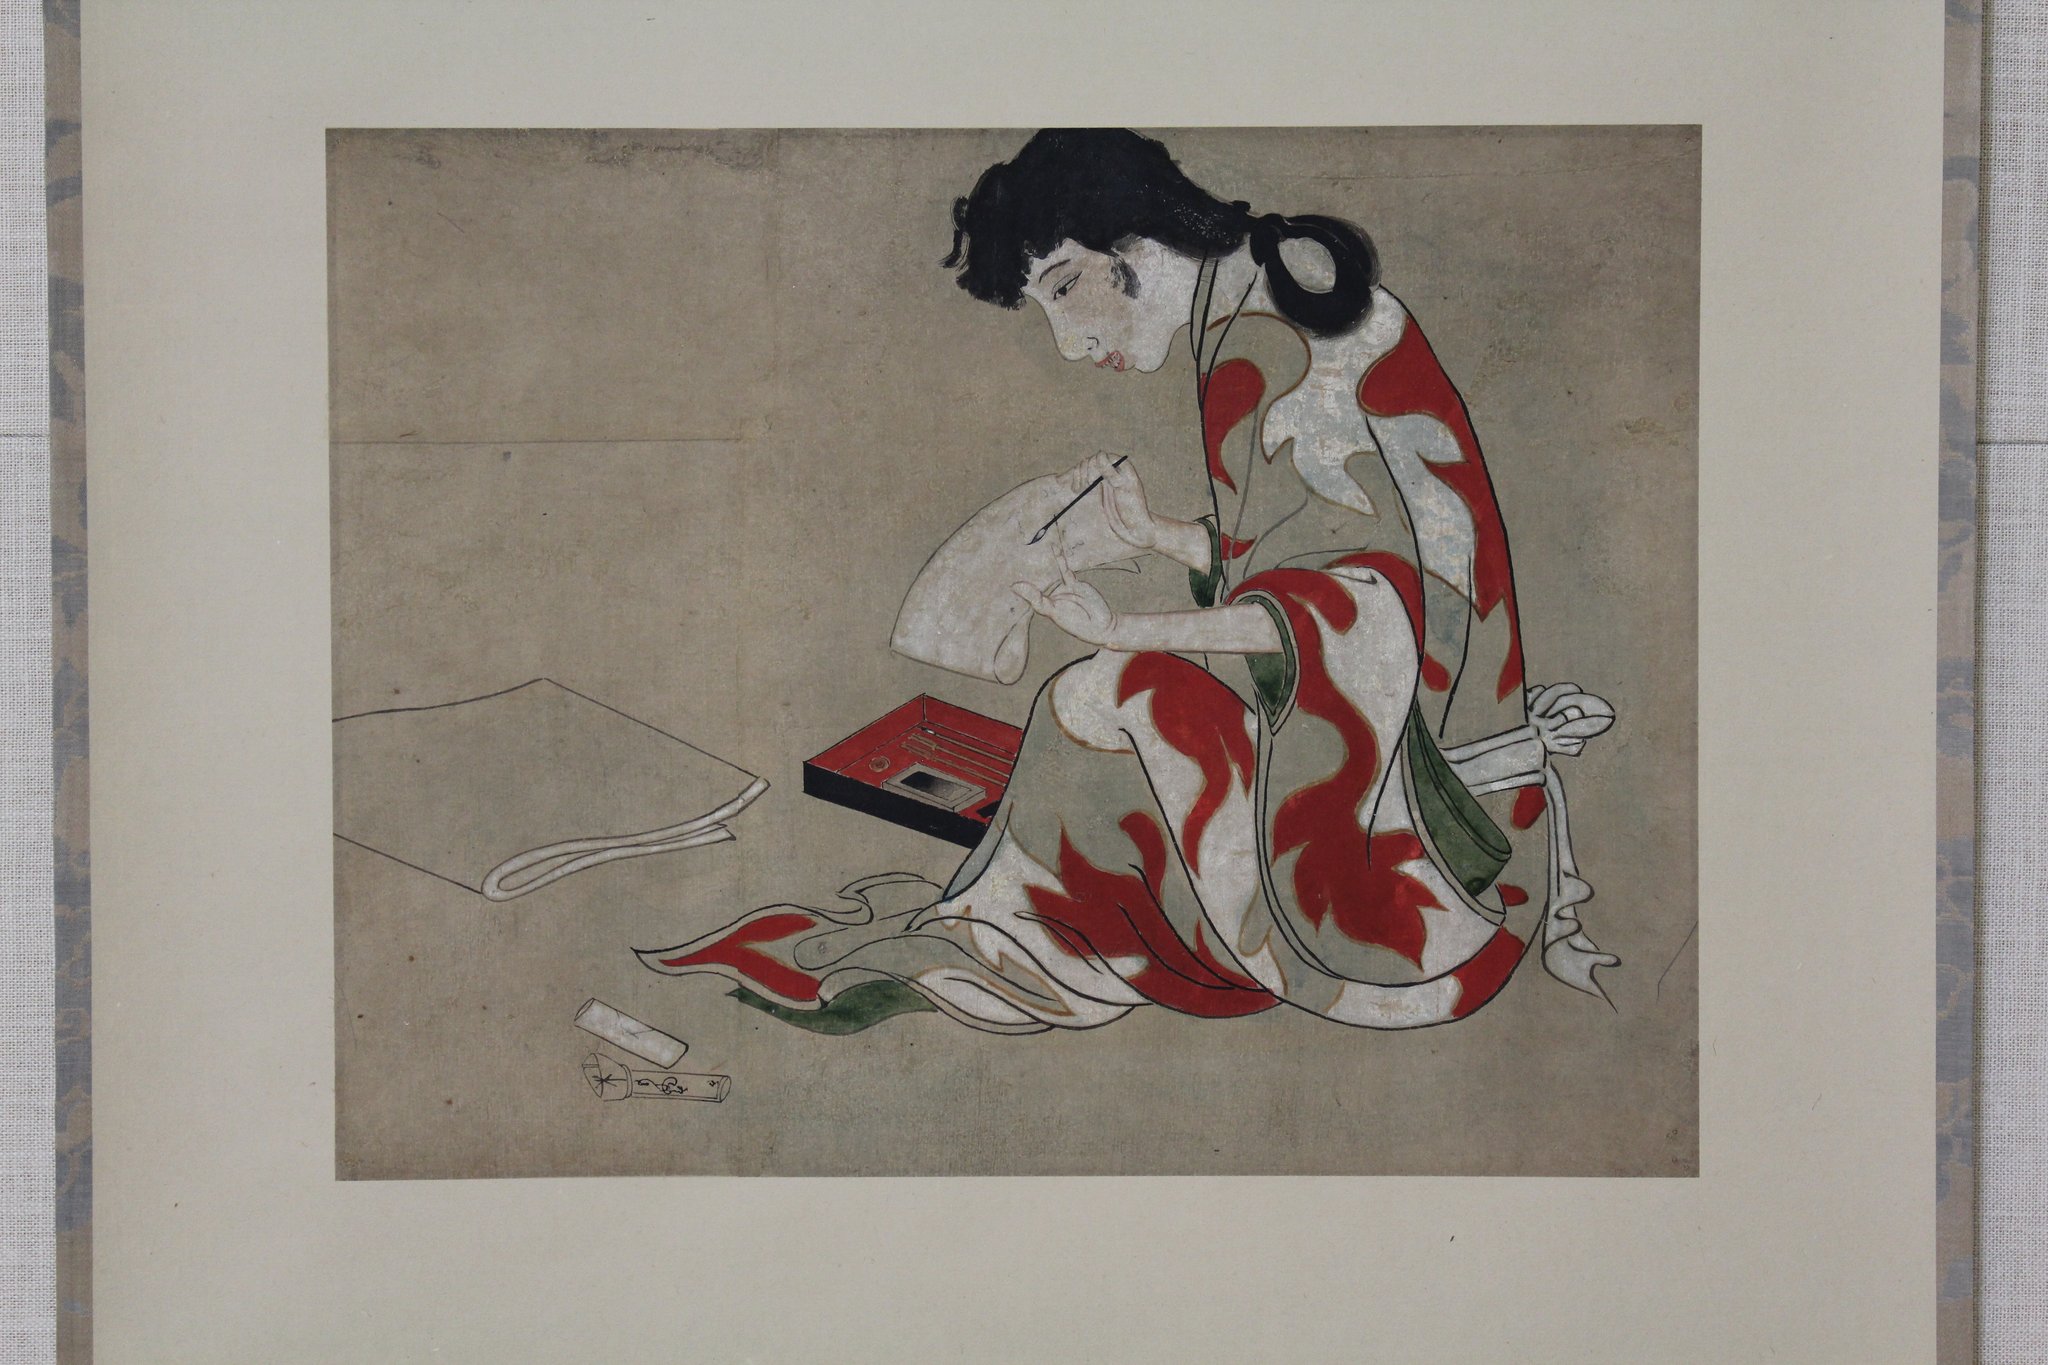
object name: hanging scroll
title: Beauty Writing a Letter (copy of a section of the Hikone Screen)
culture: japanese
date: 1601-1800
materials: ink, silk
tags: women,writing